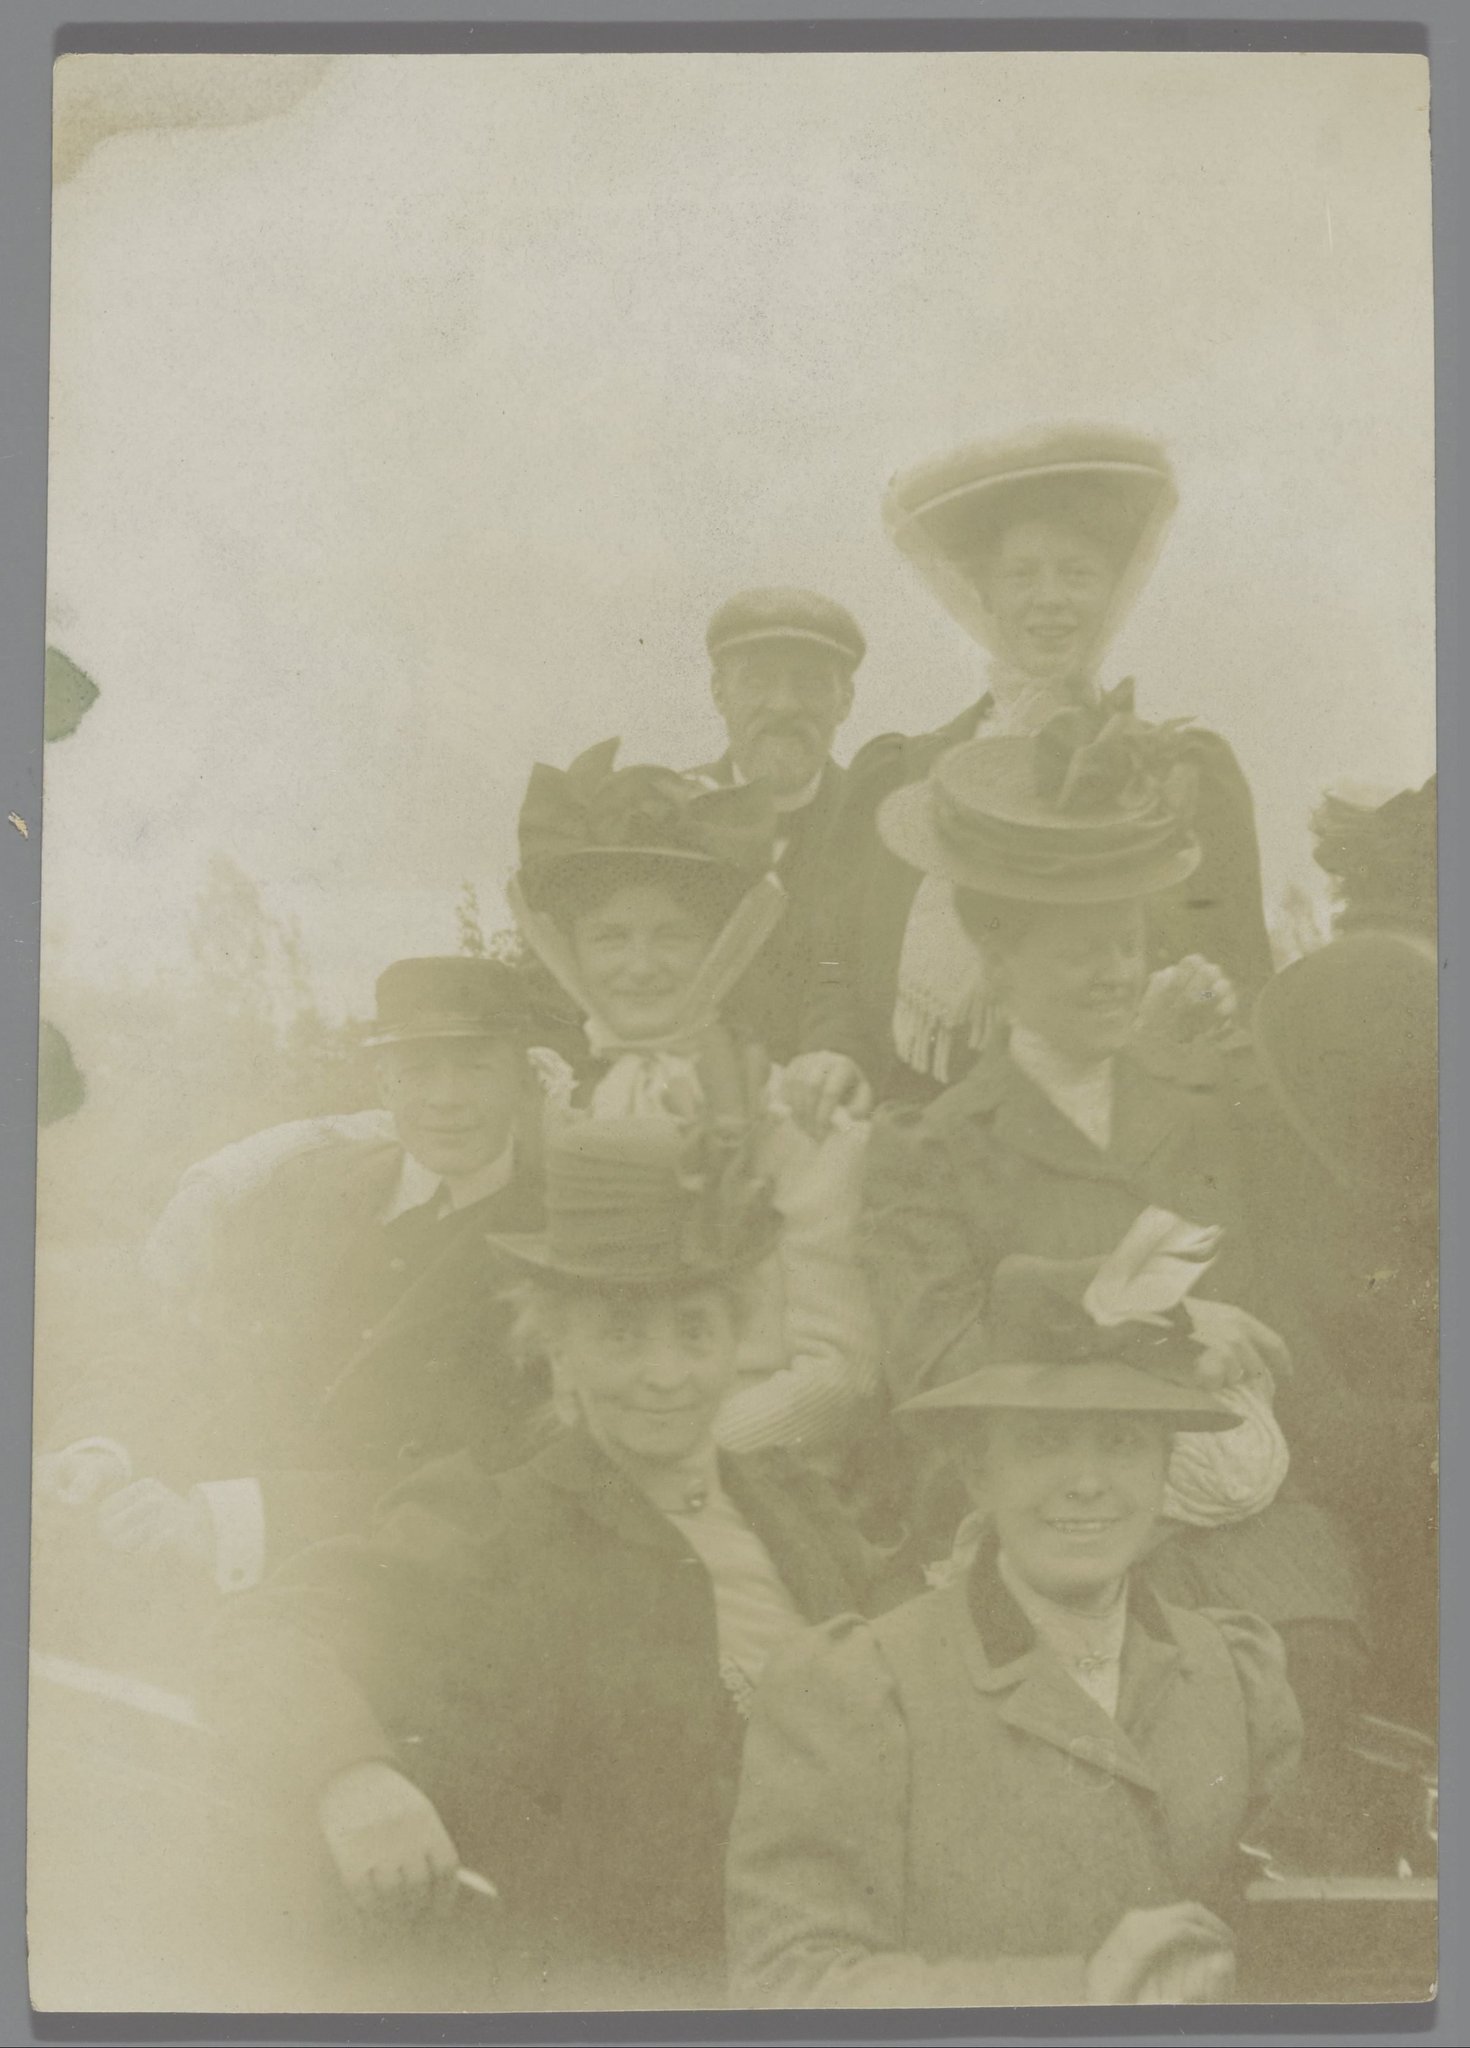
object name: photograph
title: Groepsfoto in een koets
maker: Anonymous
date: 1908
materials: paper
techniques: gelatin silver print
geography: netherlands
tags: anonymous historical persons portrayed in a group, in a group-portrait